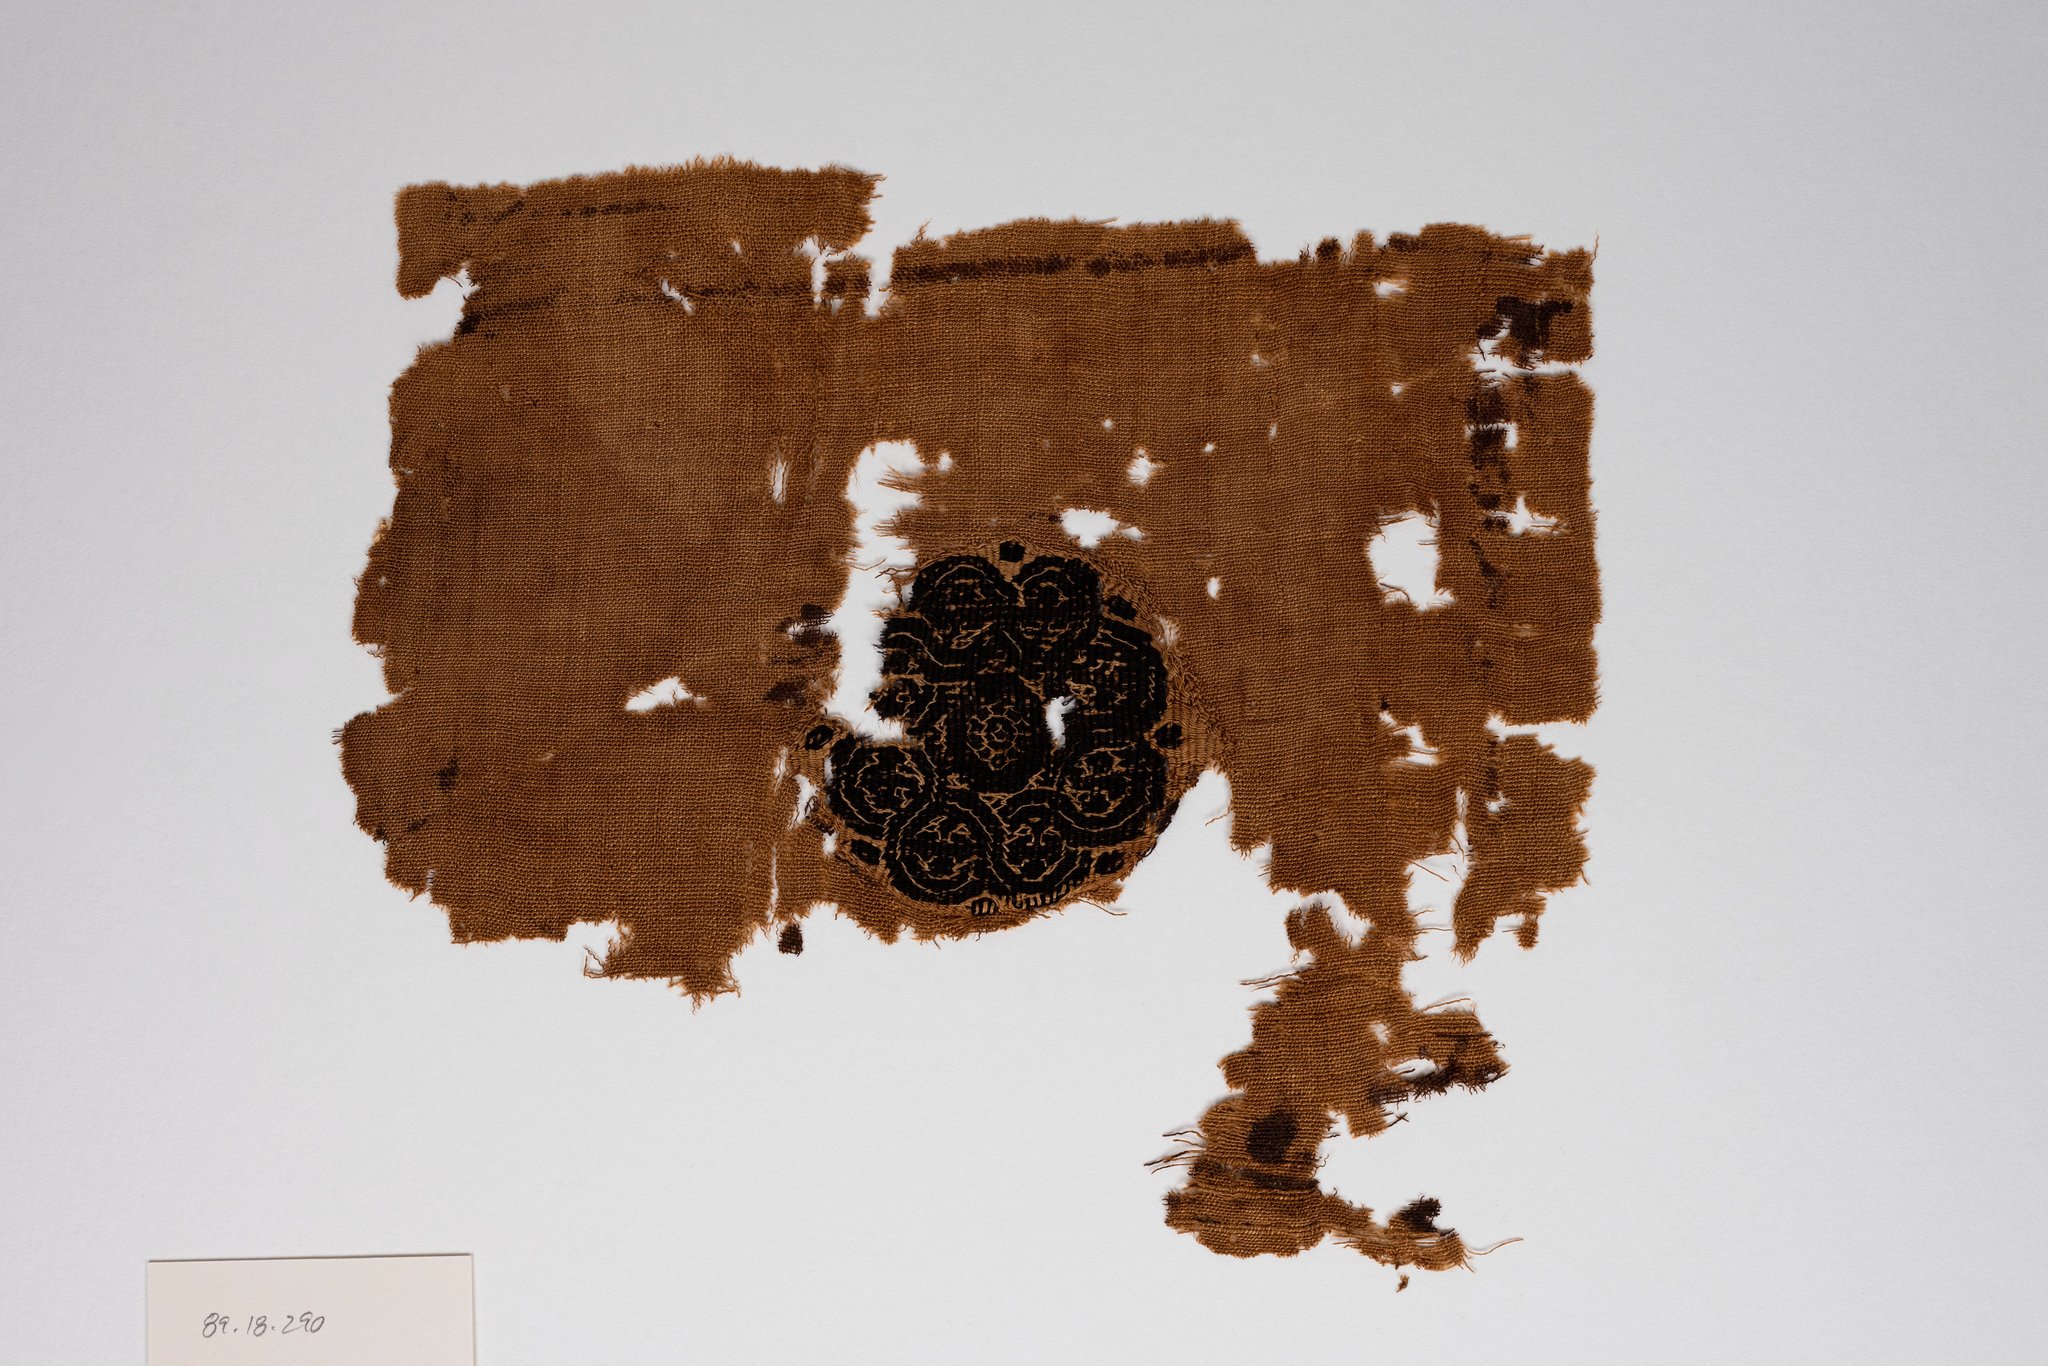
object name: textile fragment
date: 201-400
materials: linen, wool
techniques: weave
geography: egypt